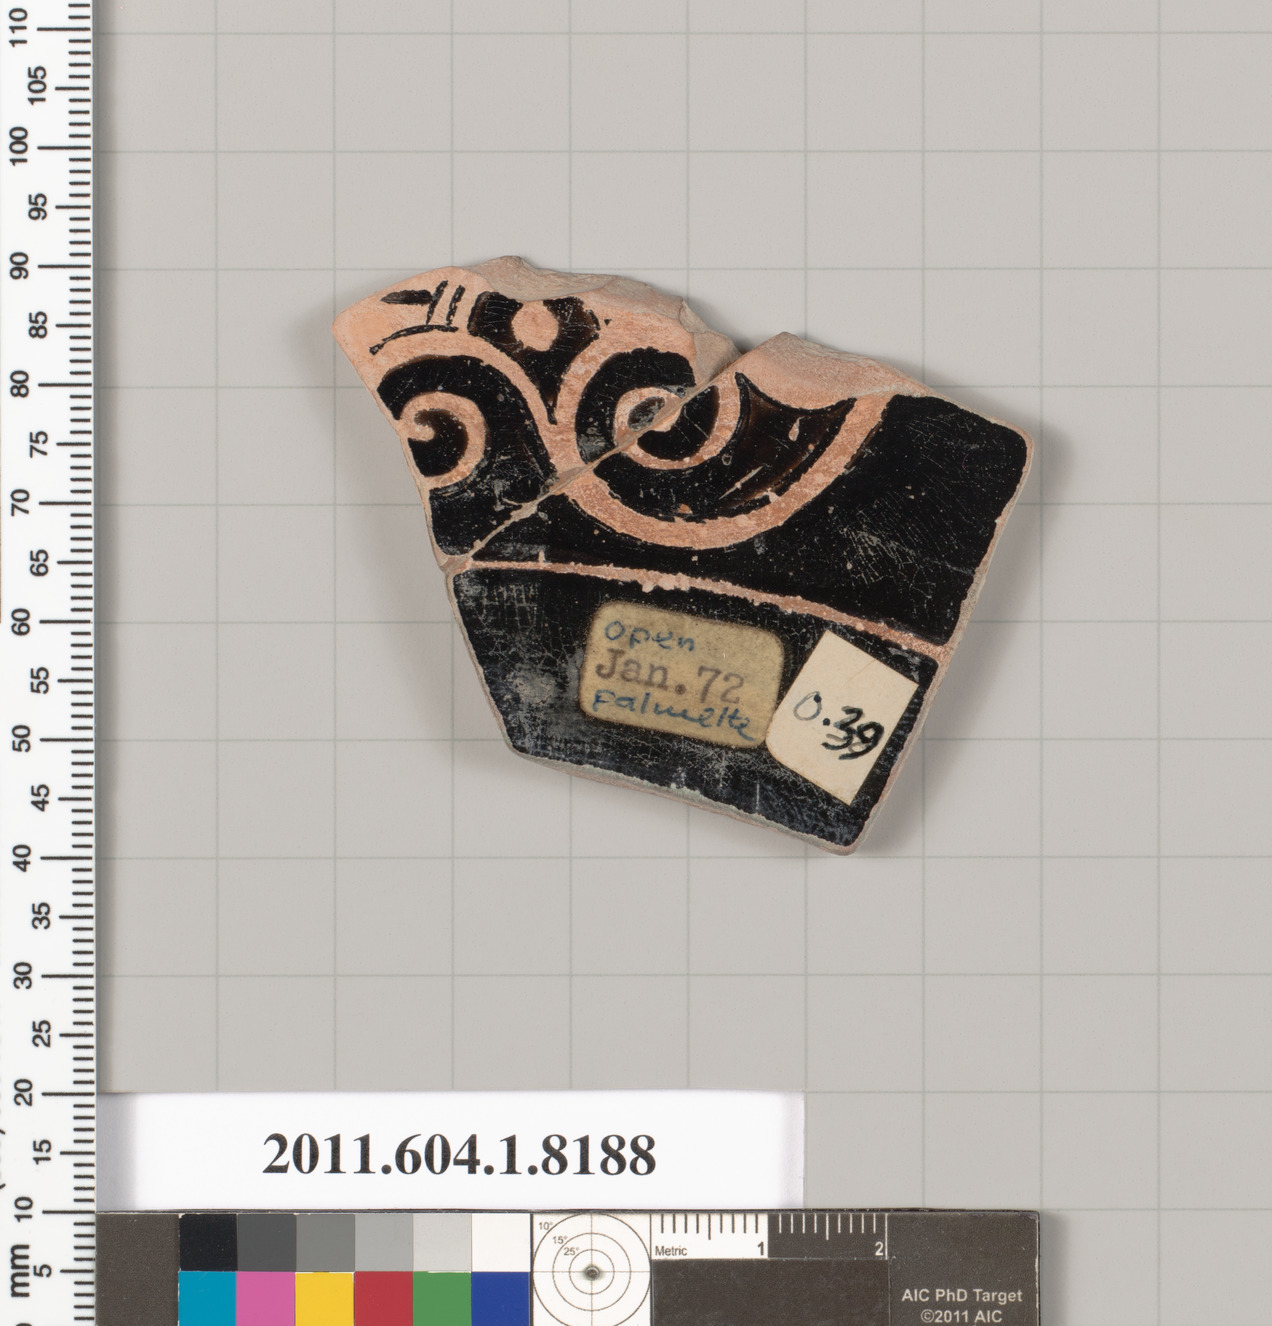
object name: kylix fragment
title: Terracotta fragment of a kylix (drinking cup)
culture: greek, attic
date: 534-468 BCE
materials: terracotta